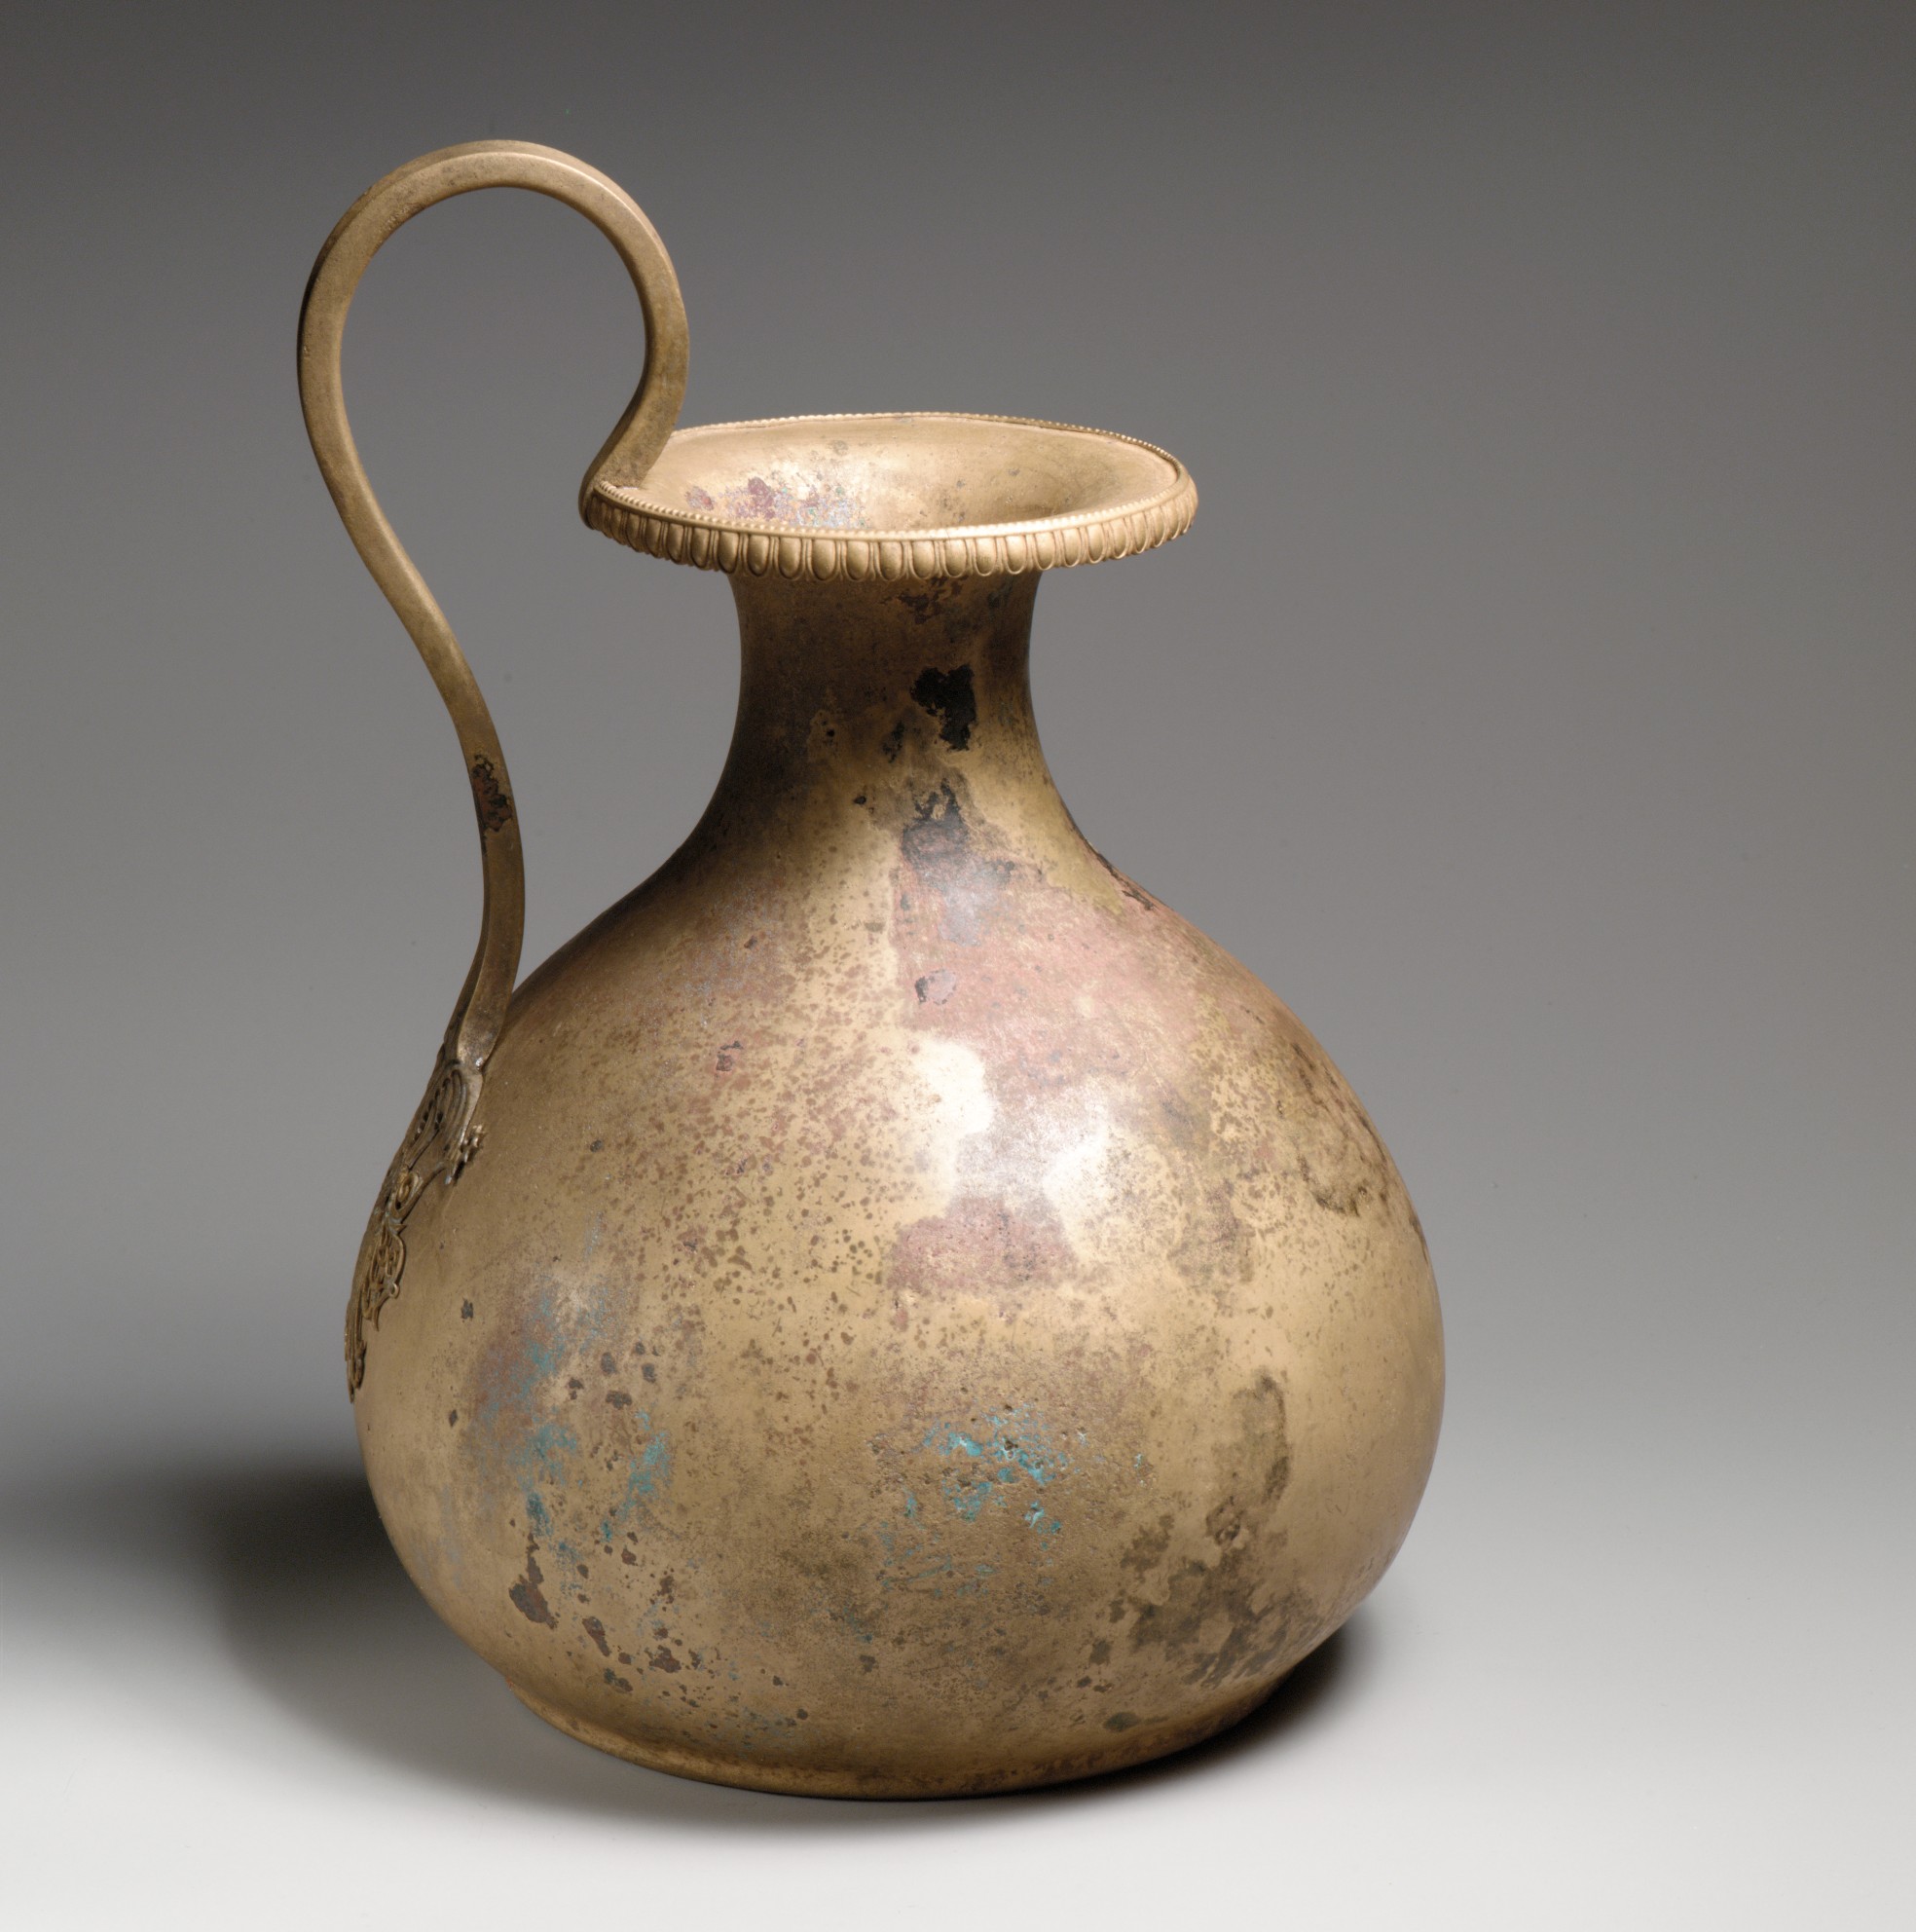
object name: oinochoe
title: Bronze oinochoe (pitcher)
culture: greek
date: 400-301 BCE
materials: bronze